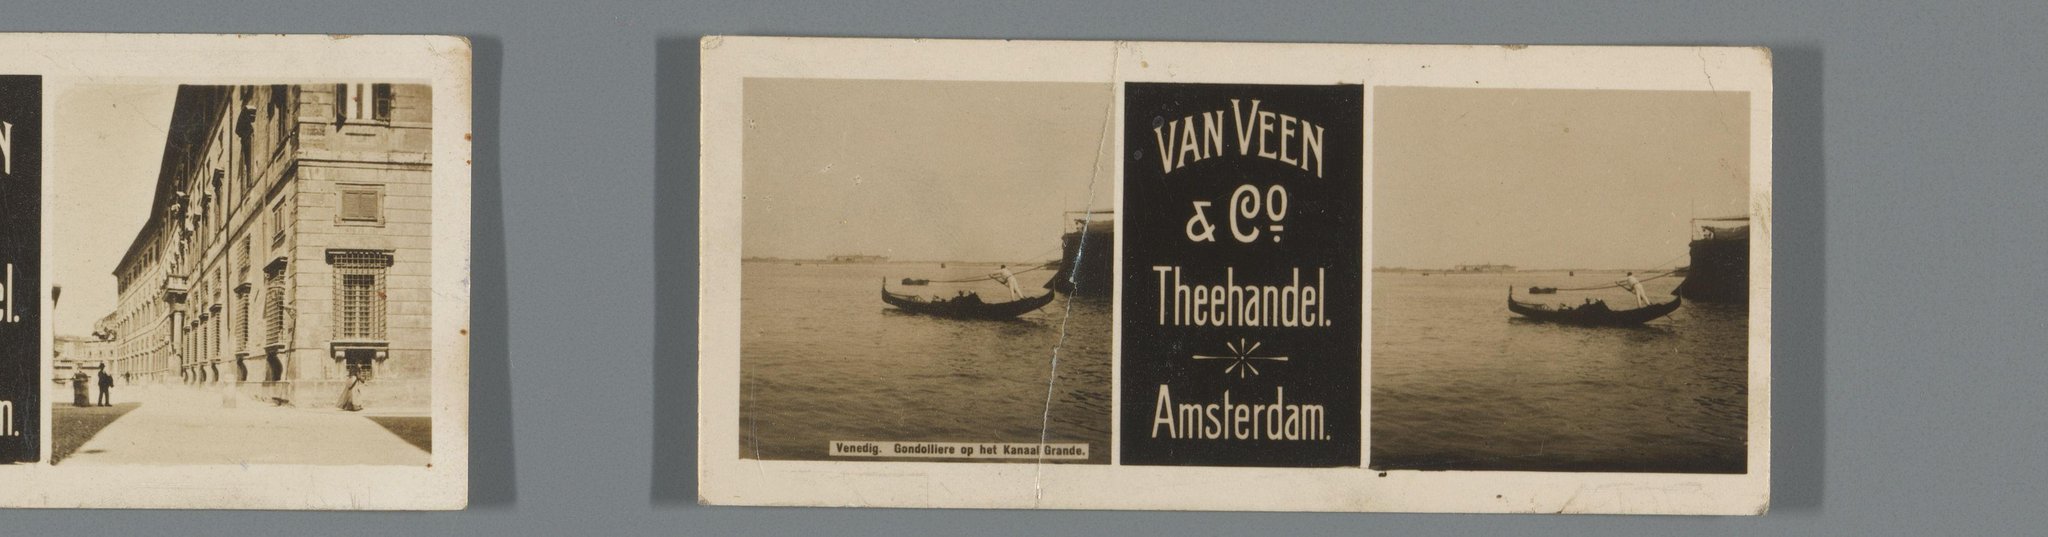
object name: stereograph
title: Gondelier op het Canal Grande in Venetië, reclame voor Theehandel van Veen & Co.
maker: Anonymous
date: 1910-1920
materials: paper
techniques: gelatin silver print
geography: venice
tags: gondola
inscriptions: inscription: ‘Venedig’